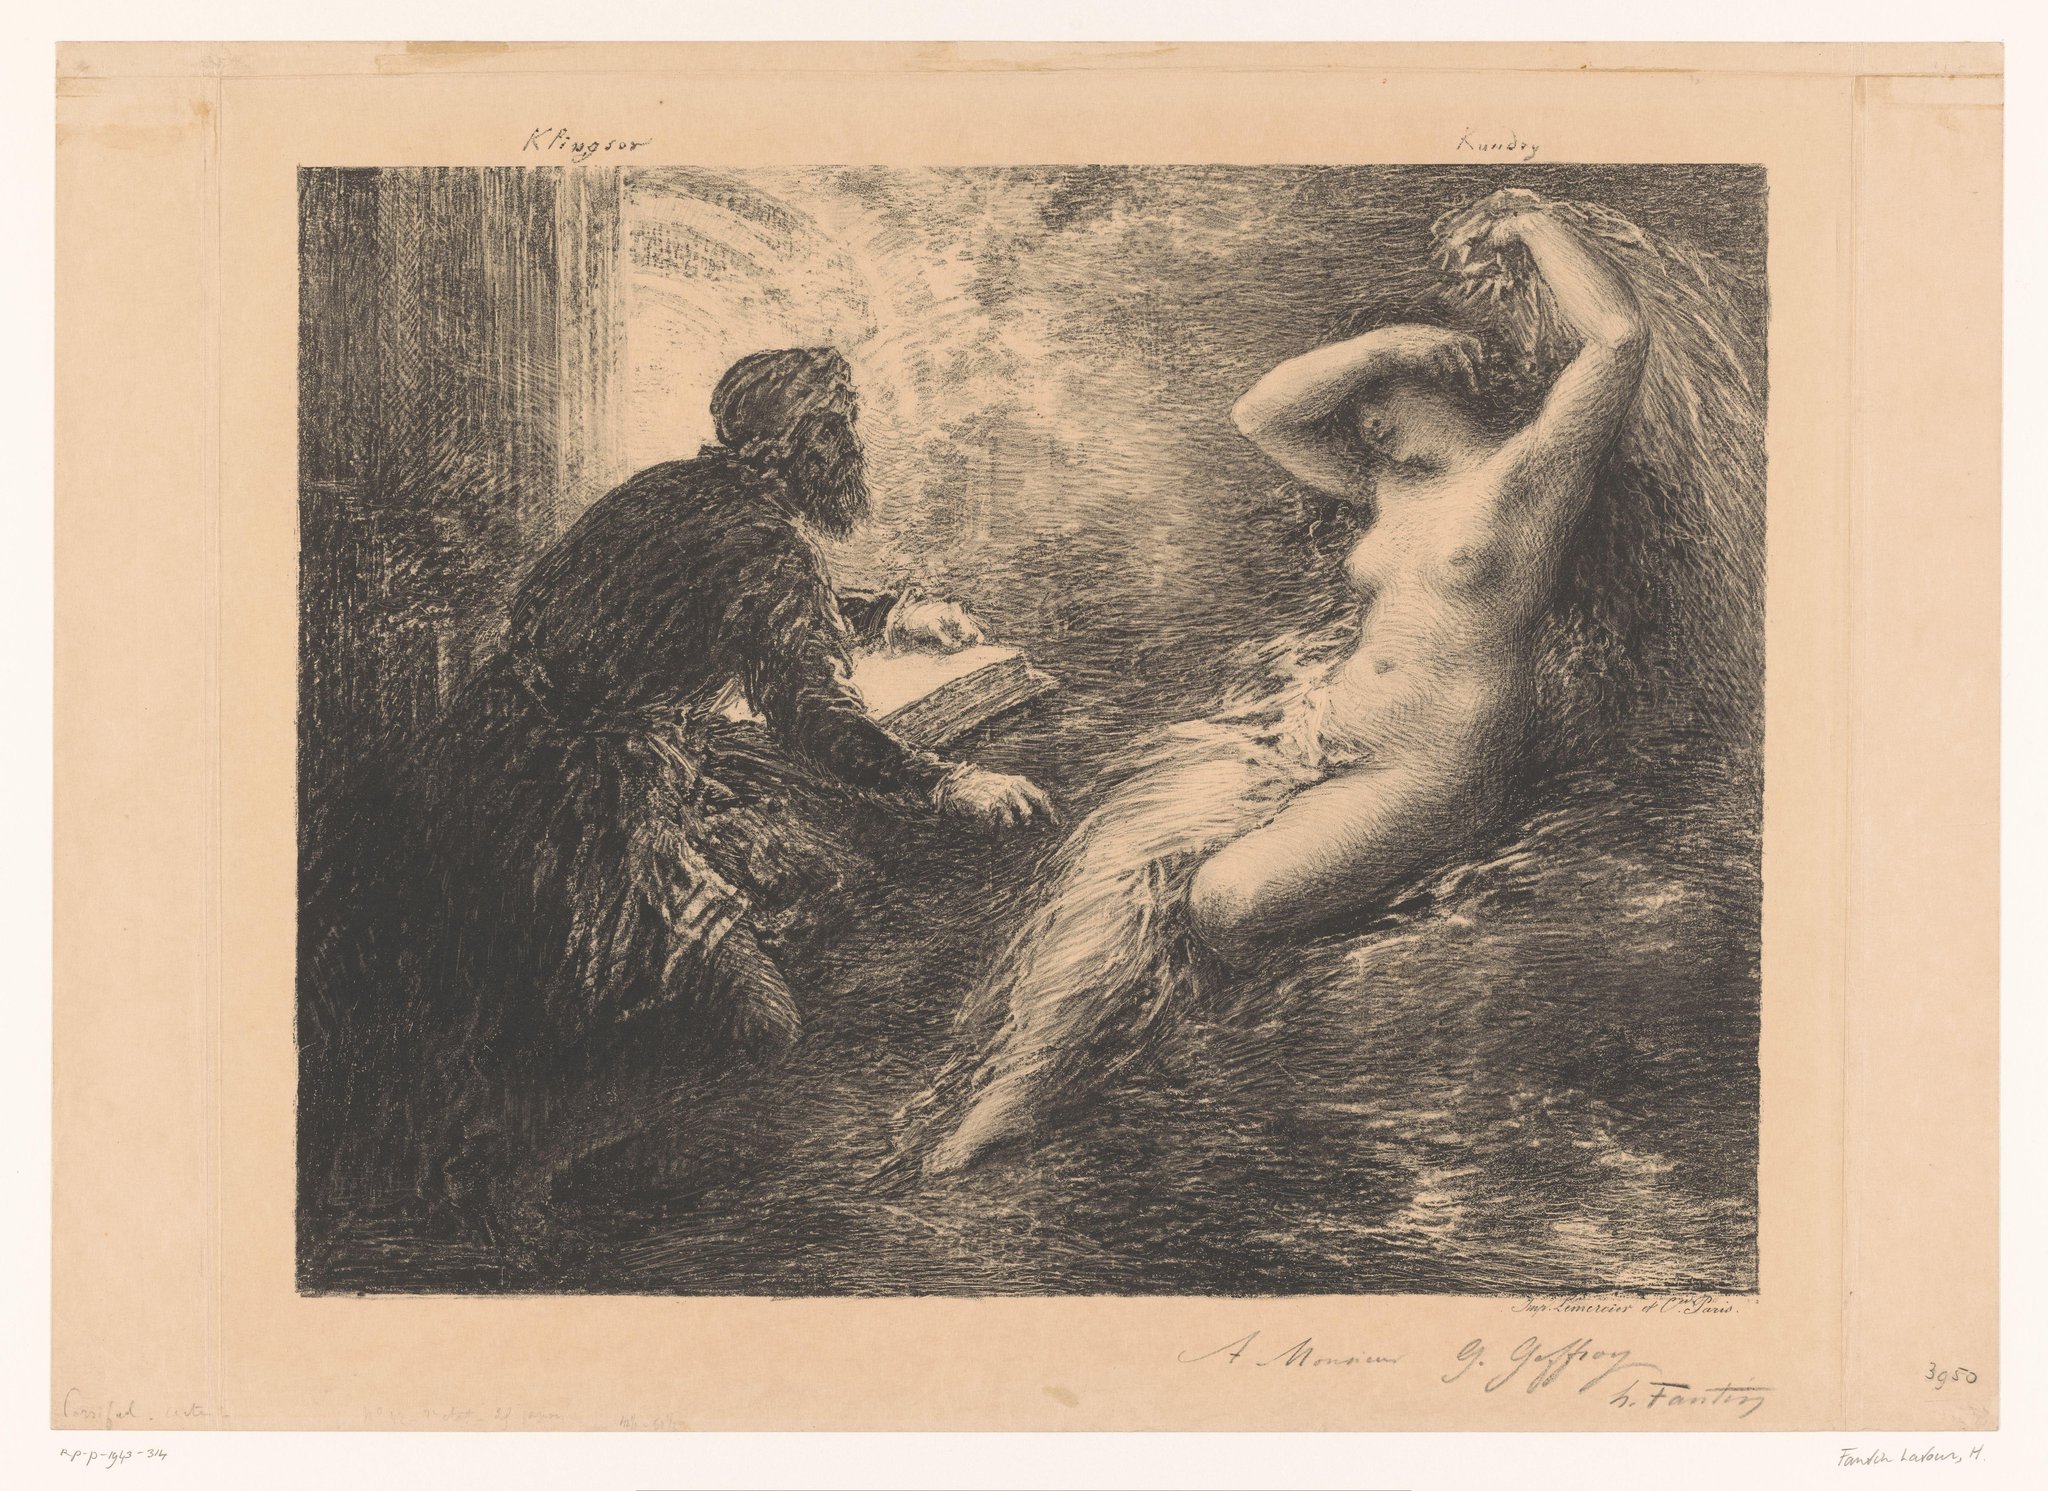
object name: print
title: Évocation de Kundry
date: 1883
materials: paper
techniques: lithography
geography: paris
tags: opera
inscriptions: collector's mark: Lugt 2760, collector's mark: Lugt 2228a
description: Scène uit de opera Parsifal van Richard Wagner.